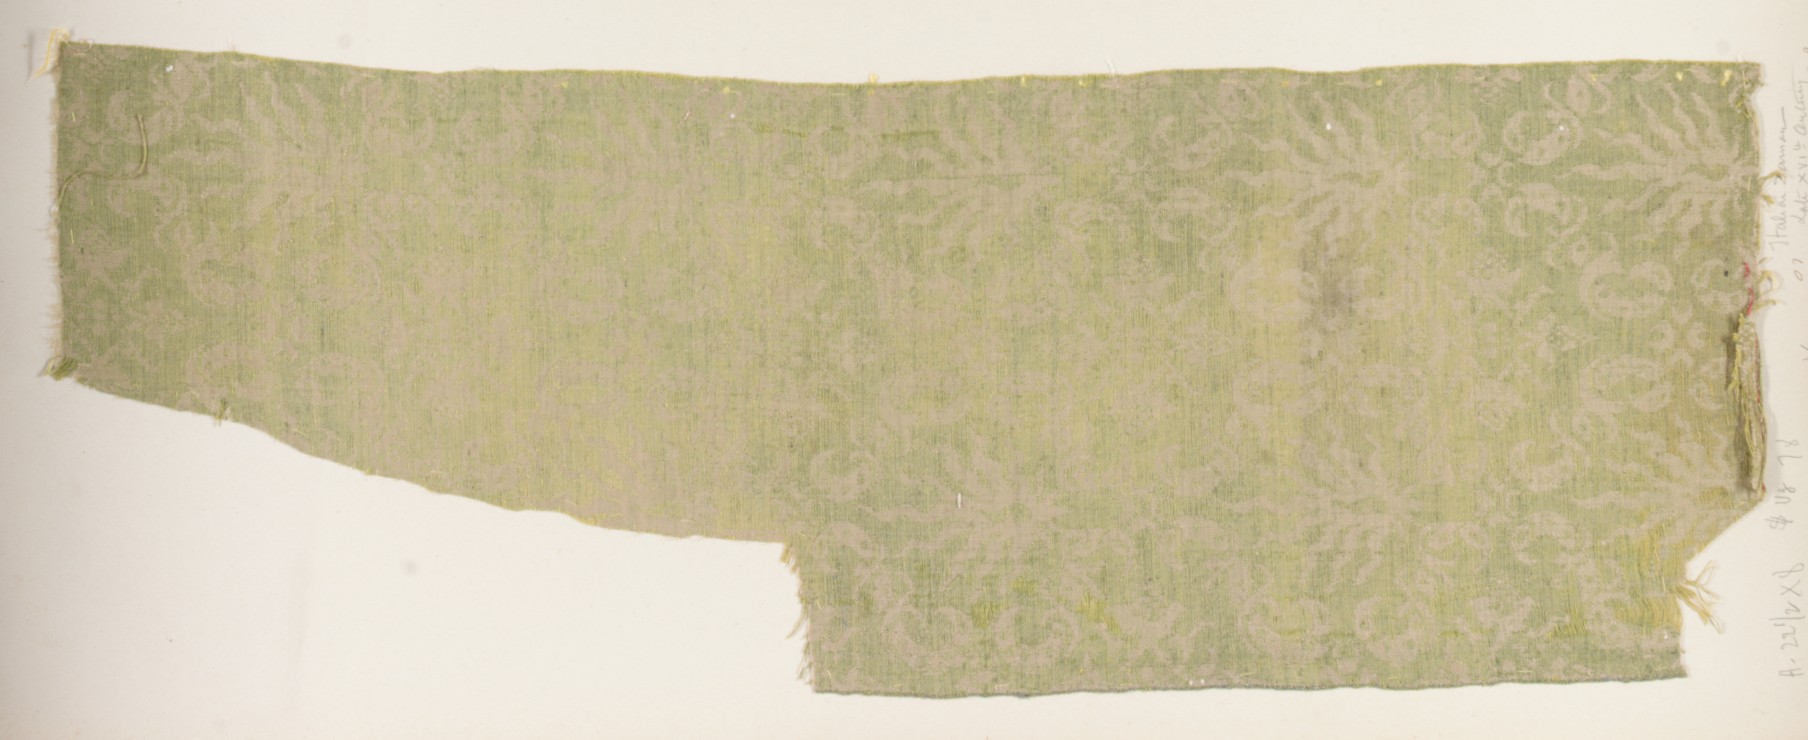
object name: fragment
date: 1567-1600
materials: silk